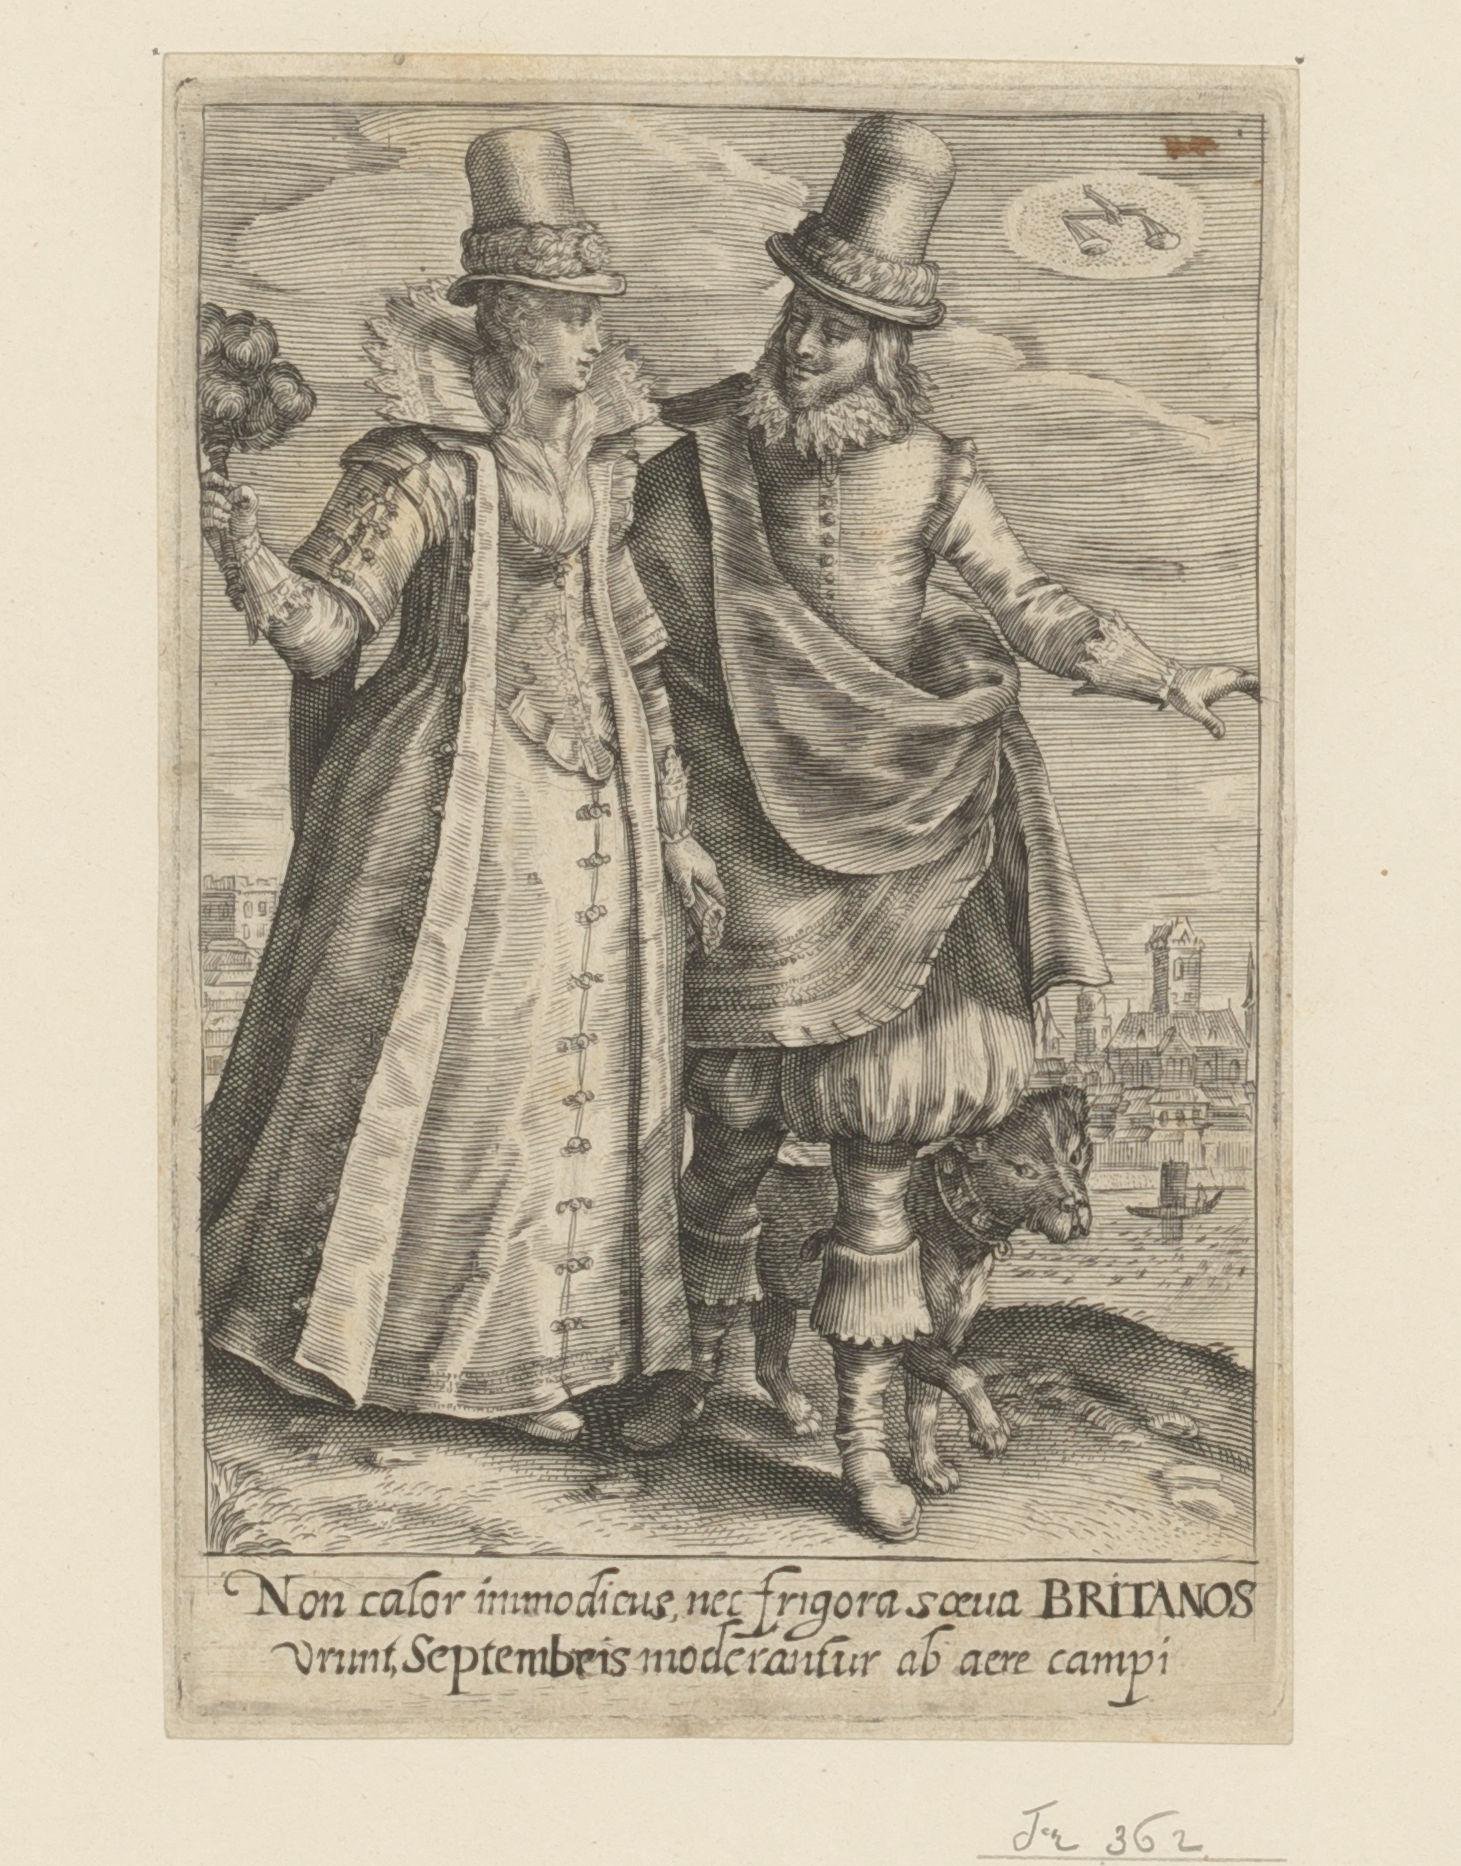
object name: print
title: September: paar uit Engeland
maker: crispijn van de passe (ii)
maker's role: draughtsman, print maker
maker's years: 1594-1670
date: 1620-1625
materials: paper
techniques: engraving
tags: taurus (zodiacal sign of april), europeans: englishmen, clothes, costume (+ women's clothes), clothes, costume (+ men's clothes), shoes, sandals, may ~ other concepts, italy, rome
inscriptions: stamp:, collector's mark: Lugt 963, collector's mark: Lugt 1641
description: Man en vrouw, gekleed volgens de Engelse mode van ca. 1620. De vrouw heeft een veren stokwaaier in de hand. Naast de man een hond. Op de achtergrond een stadsgezicht. Rechtsboven het teken van het sterrenbeeld weegschaal. In de marge een tweeregelig onderschrift in het Latijn over het gematigde klimaat en Engeland. Prent uit een serie met de twaalf maanden weergegeven door tekens van de dierenriem en paren die kleding uit verschillende landen dragen. Onderwerpsrubrieken binnen de Atlas Zeden en Gewoonten: Zeden en Gewoonten in Engeren Zin, De Kleeding, Kleederdrachten (tijdvakken), Het begin der 17de eeuw. (De Fransche mode).